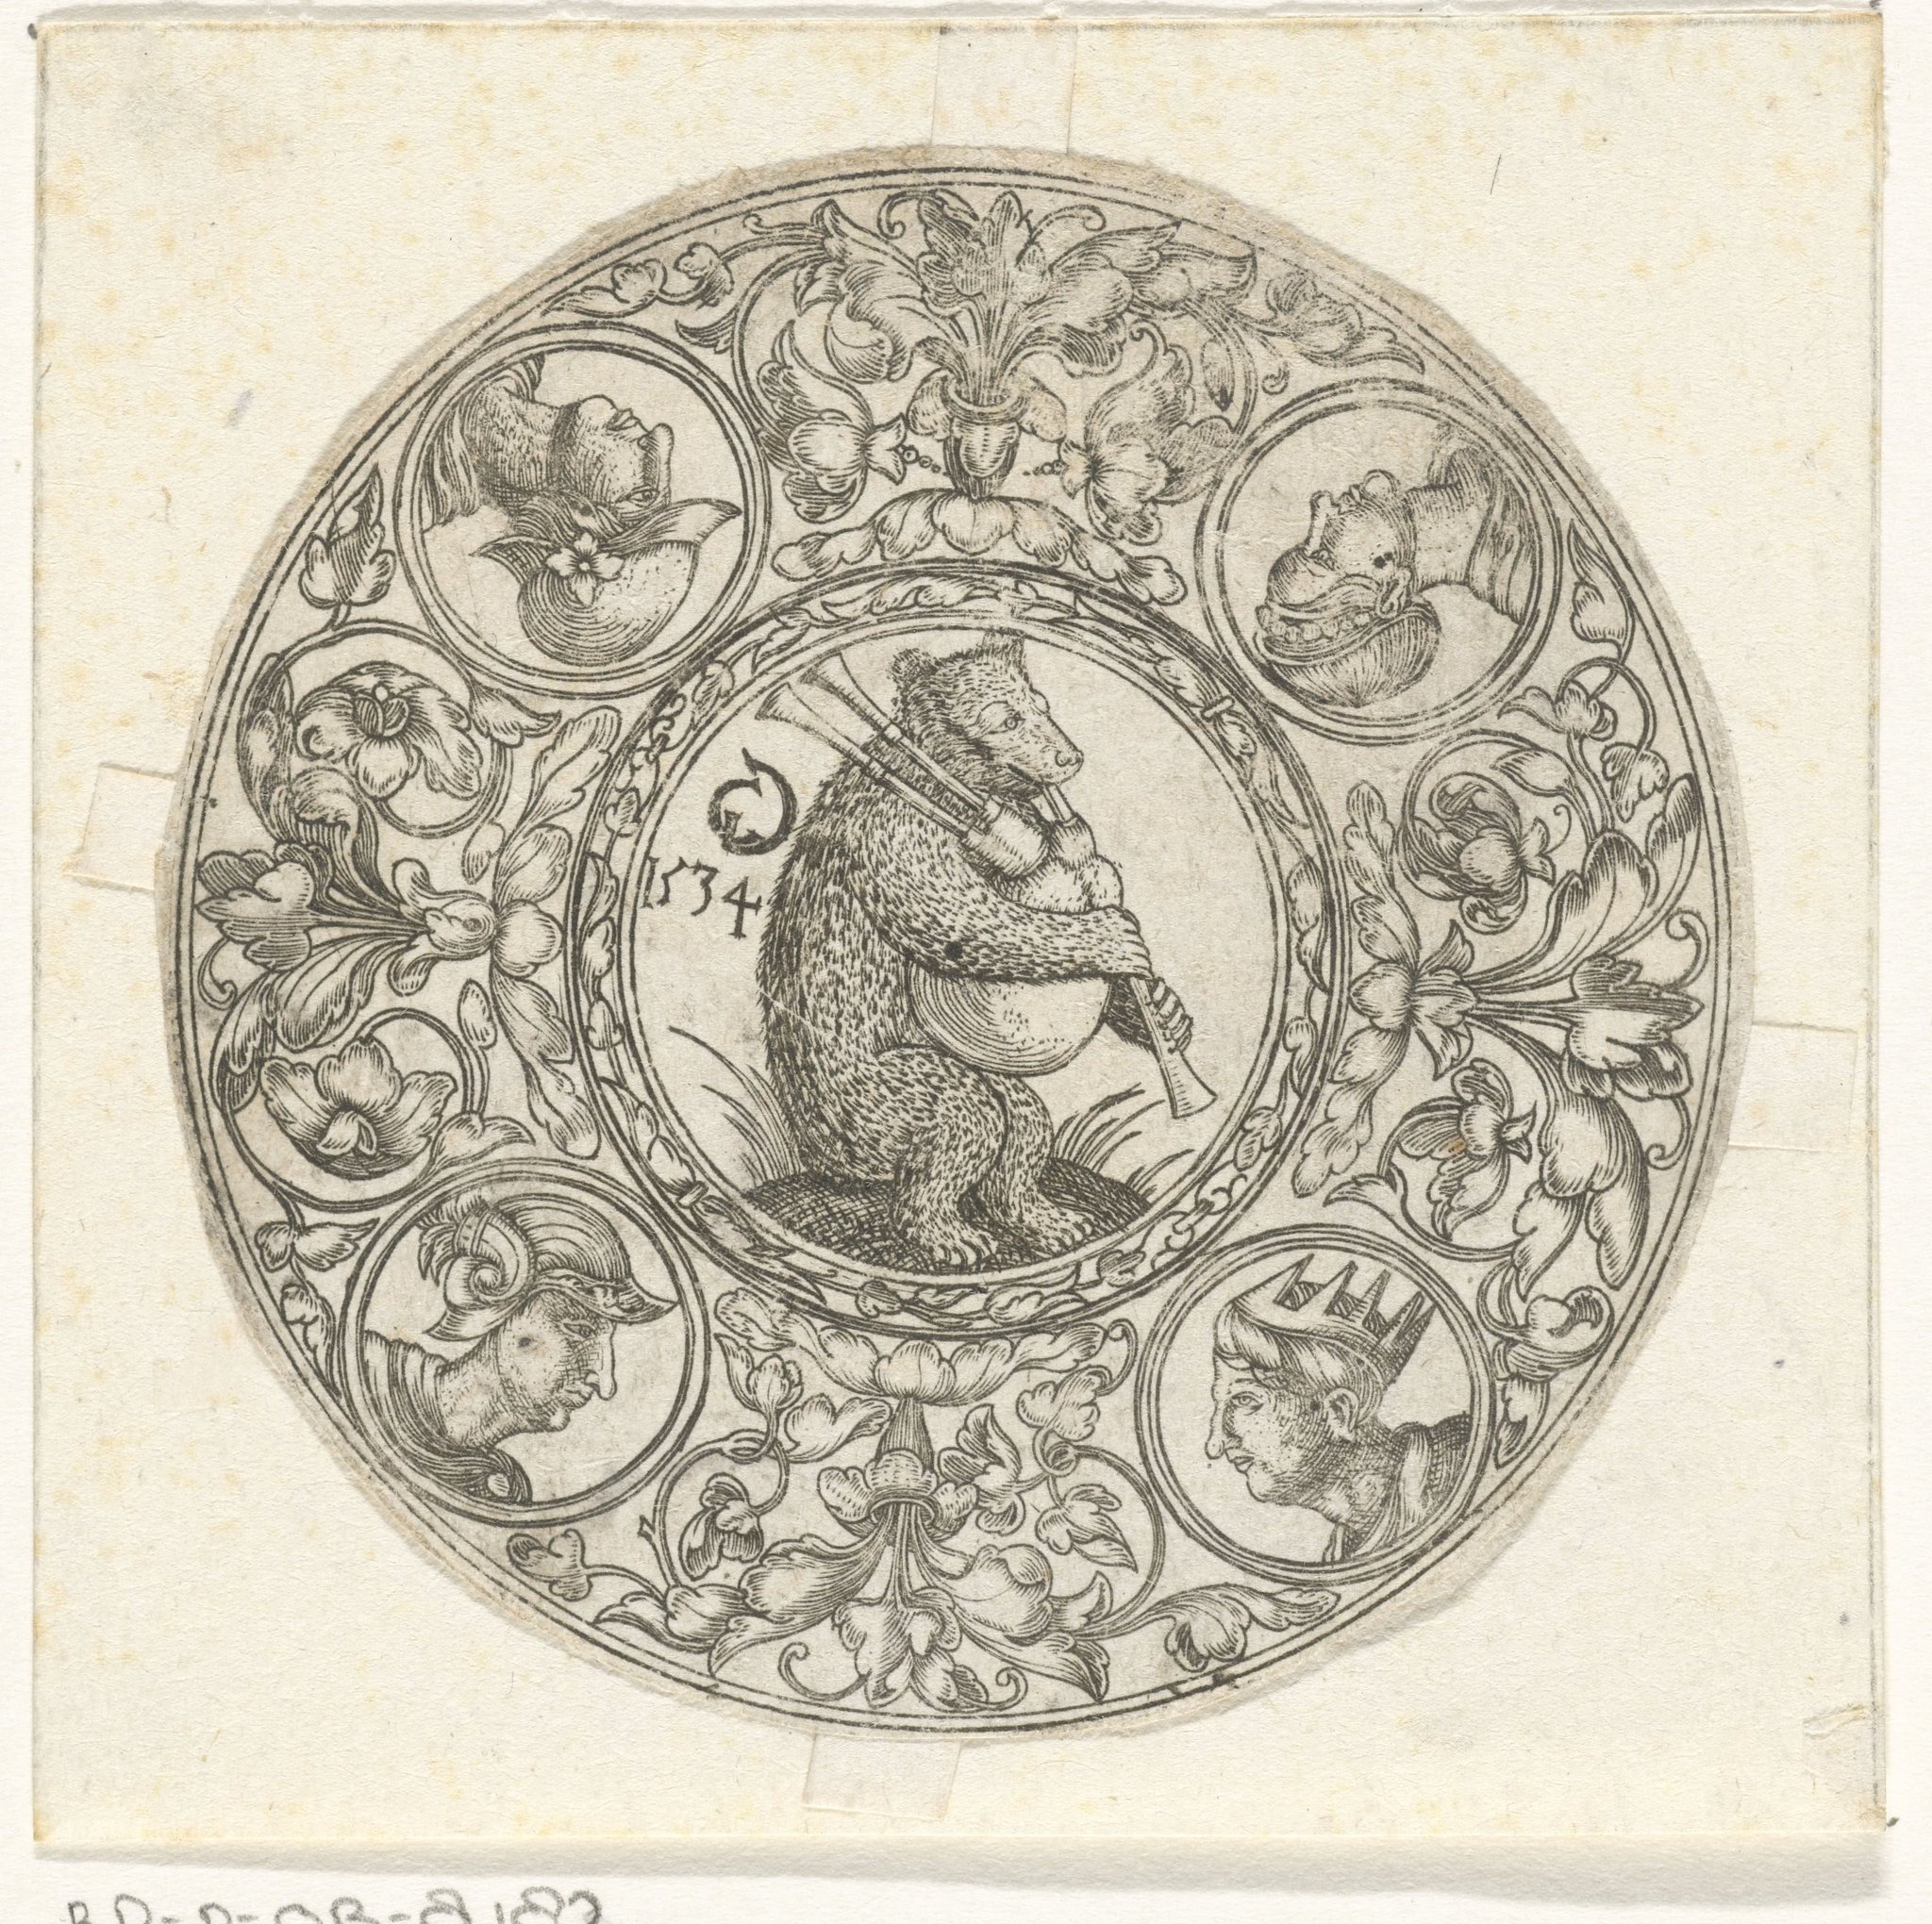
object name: print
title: Rond blad met beer die de doedelzak bespeelt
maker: monogrammist cg (duitsland)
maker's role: print maker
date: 1534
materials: paper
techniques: engraving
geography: germany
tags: one person playing wind instrument, bagpipe, musette, animals acting as human beings, ornament ~ medallion, beasts of prey, predatory animals: bear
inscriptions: collector's mark: Lugt 240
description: De beer speelt op een doeldelzak en is omringd door een rand, gedecoreerd met bladranken en vier medaillons.